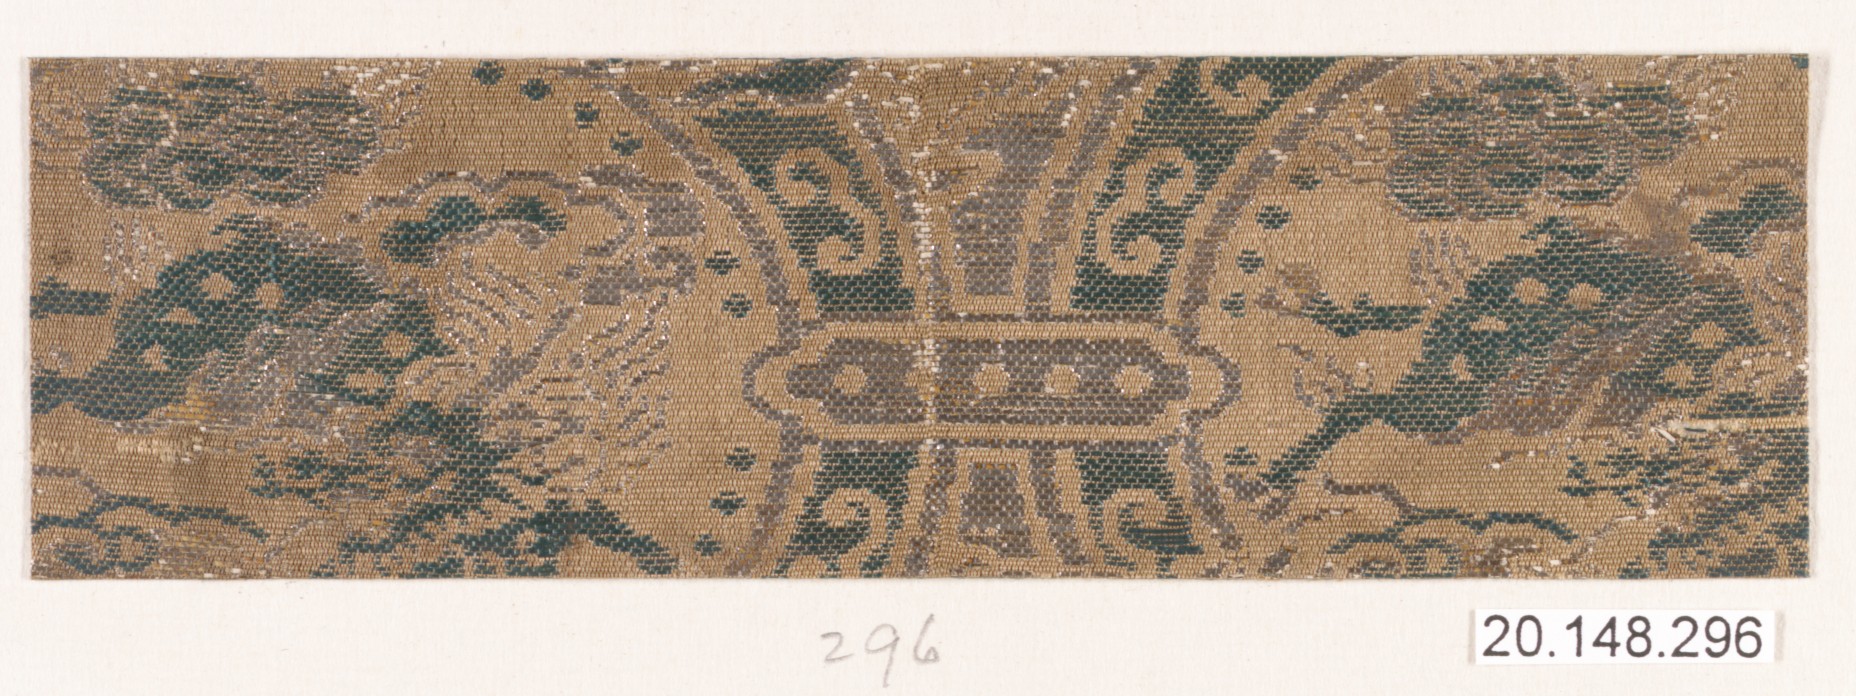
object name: piece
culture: japanese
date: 1701-1800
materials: silk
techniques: compound weave